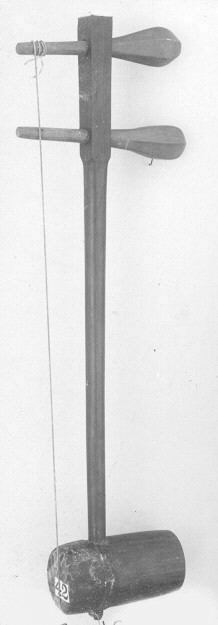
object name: erxian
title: Erxian (二弦)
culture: chinese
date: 1801-1900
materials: bone, skin, wood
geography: china